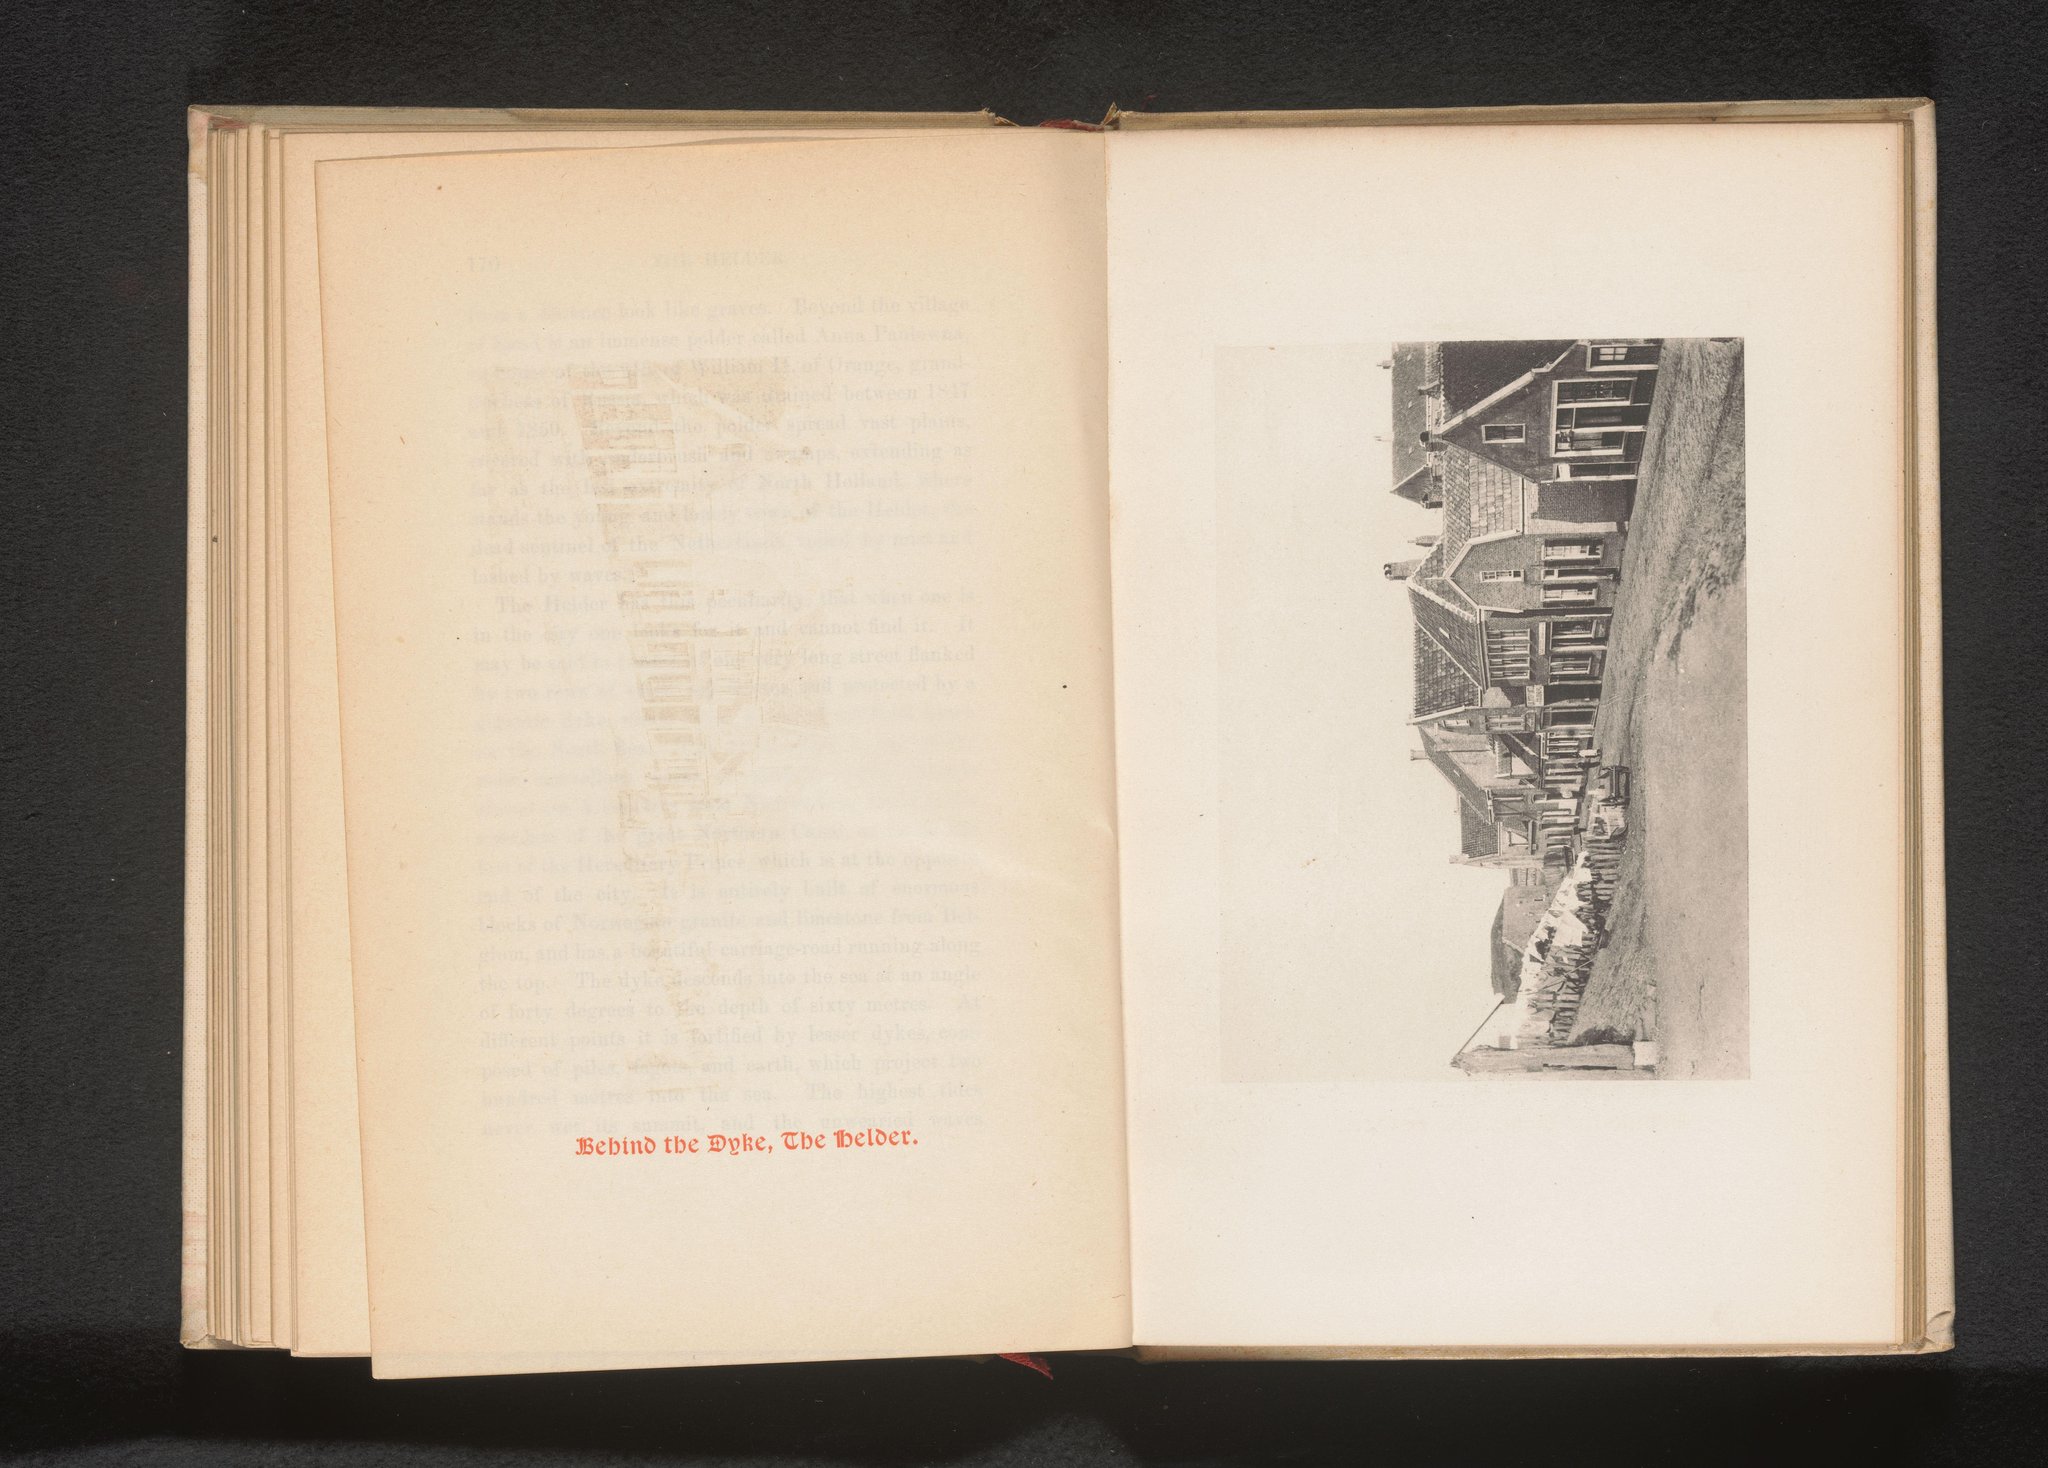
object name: page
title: Straat te Den Helder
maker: charles l. mitchell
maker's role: fotograaf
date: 1884-1894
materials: paper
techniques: photoaquatint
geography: den helder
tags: façade (of house or building), street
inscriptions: title: ‘Behind the Dyke, The Helder.’